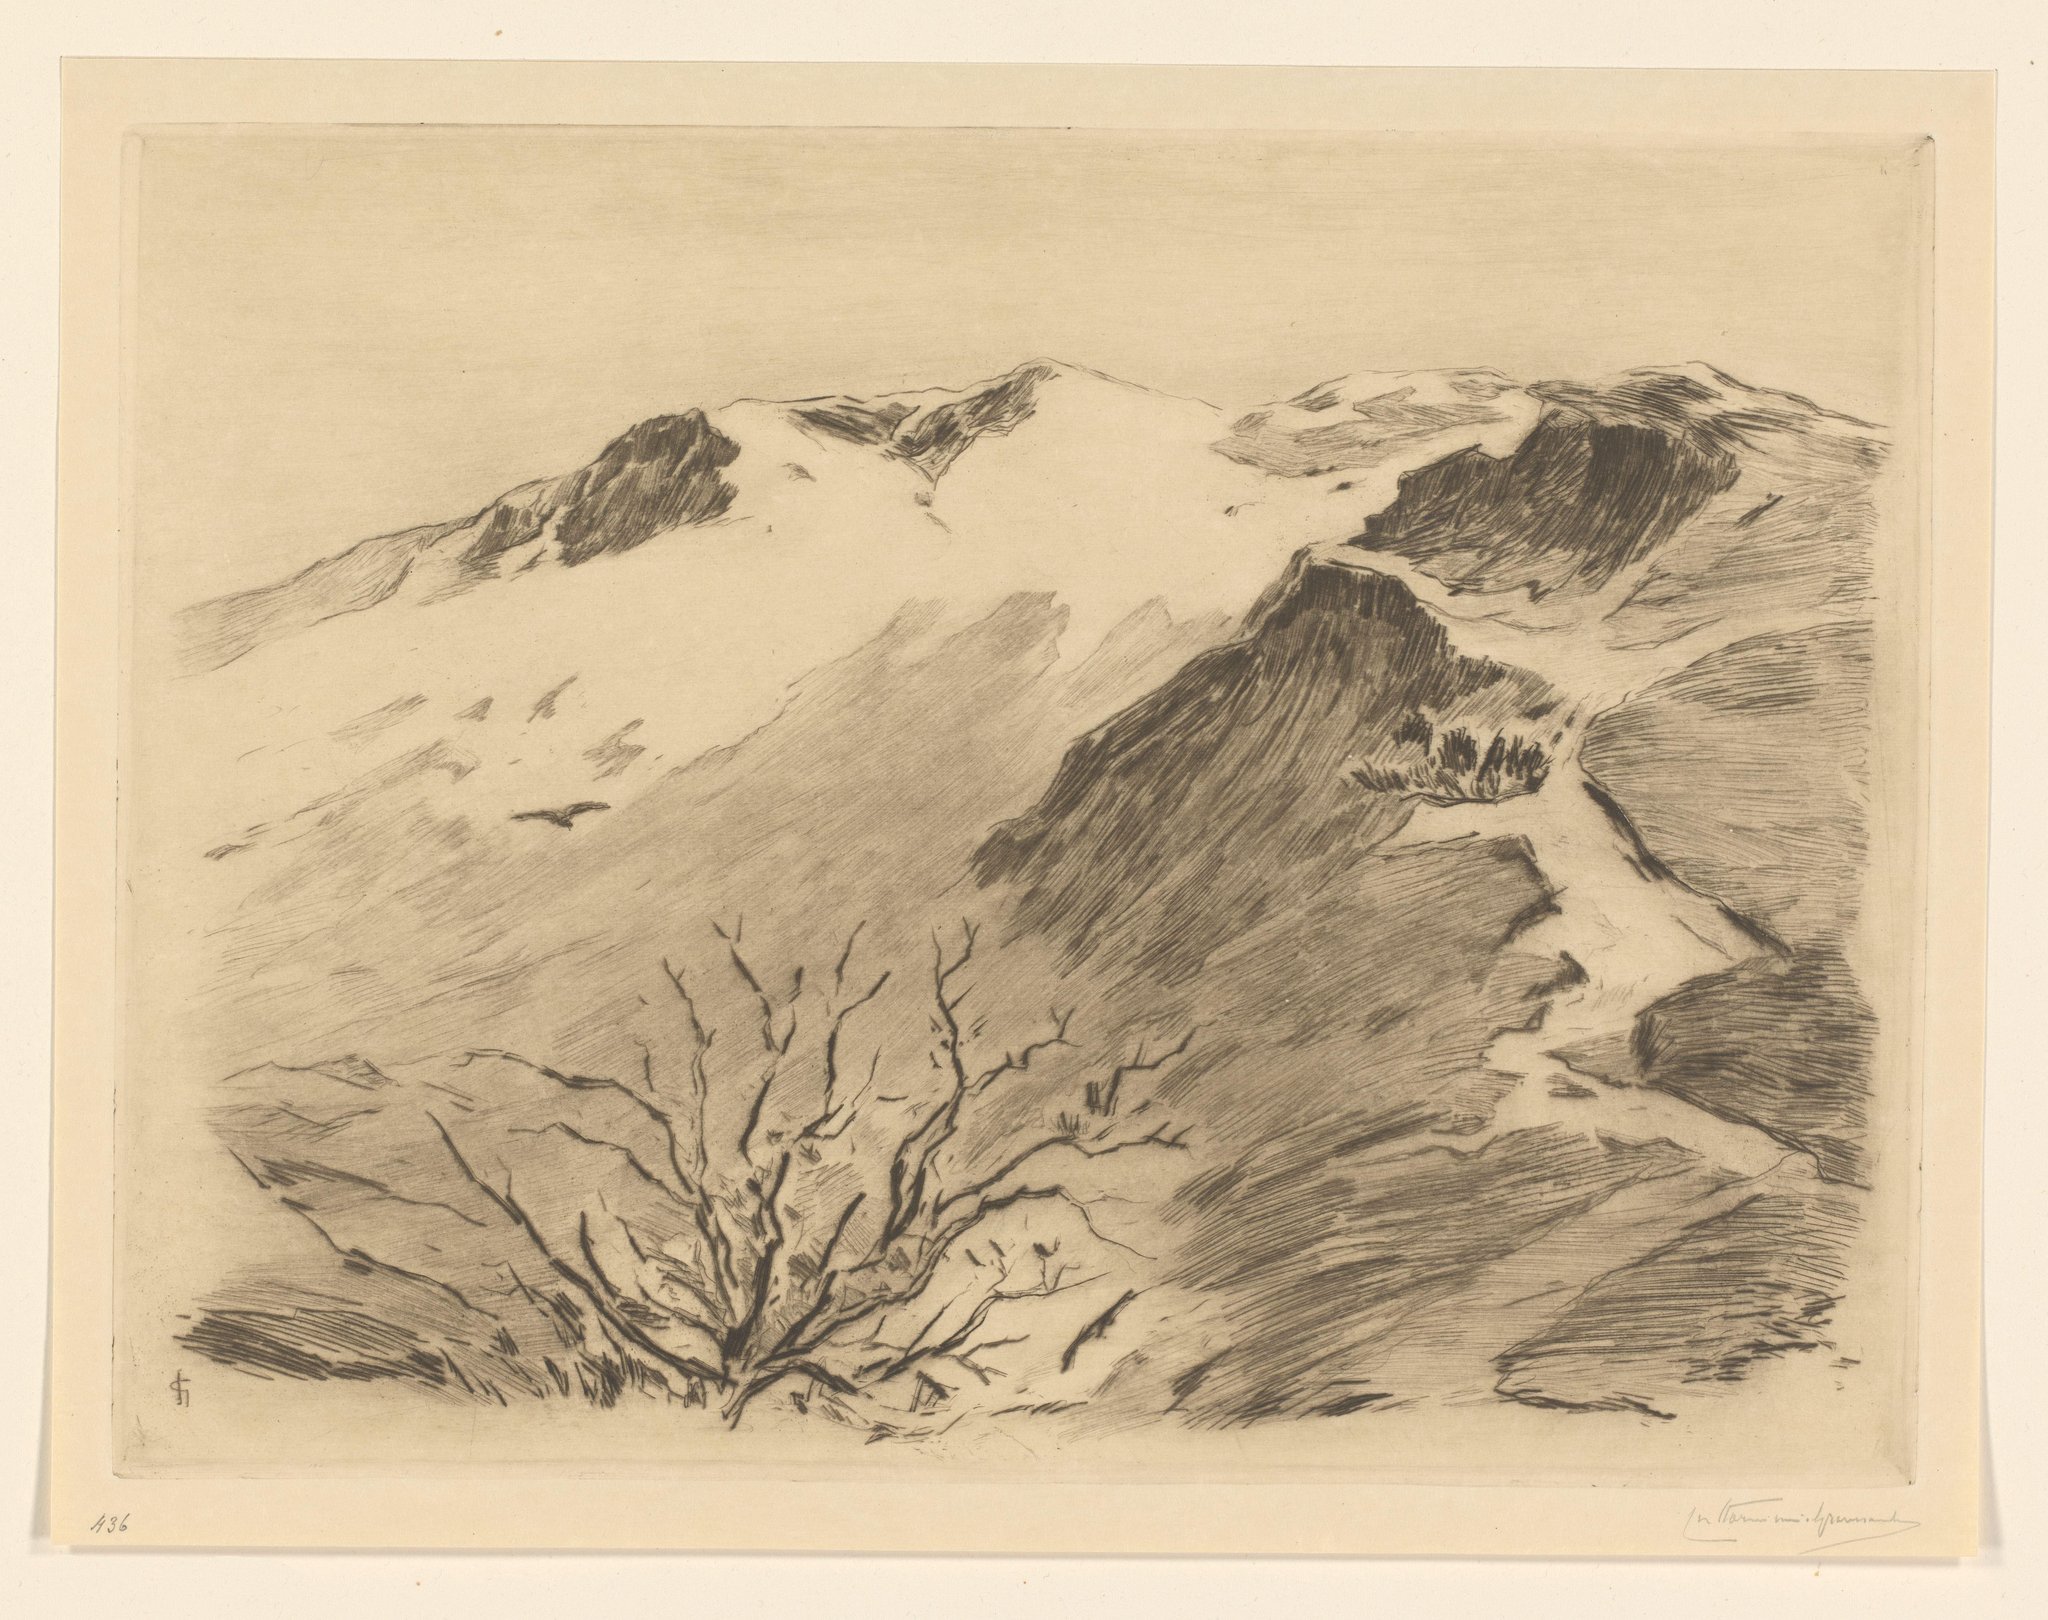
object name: print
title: Sneeuw in de duinen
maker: carel nicolaas storm van s-gravesande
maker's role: draughtsman, print maker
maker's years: 1841-1924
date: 1851-1902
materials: paper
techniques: drypoint, intaglio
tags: dunes (sea not visible); in the dunes, snow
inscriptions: collector's mark: Lugt 2228